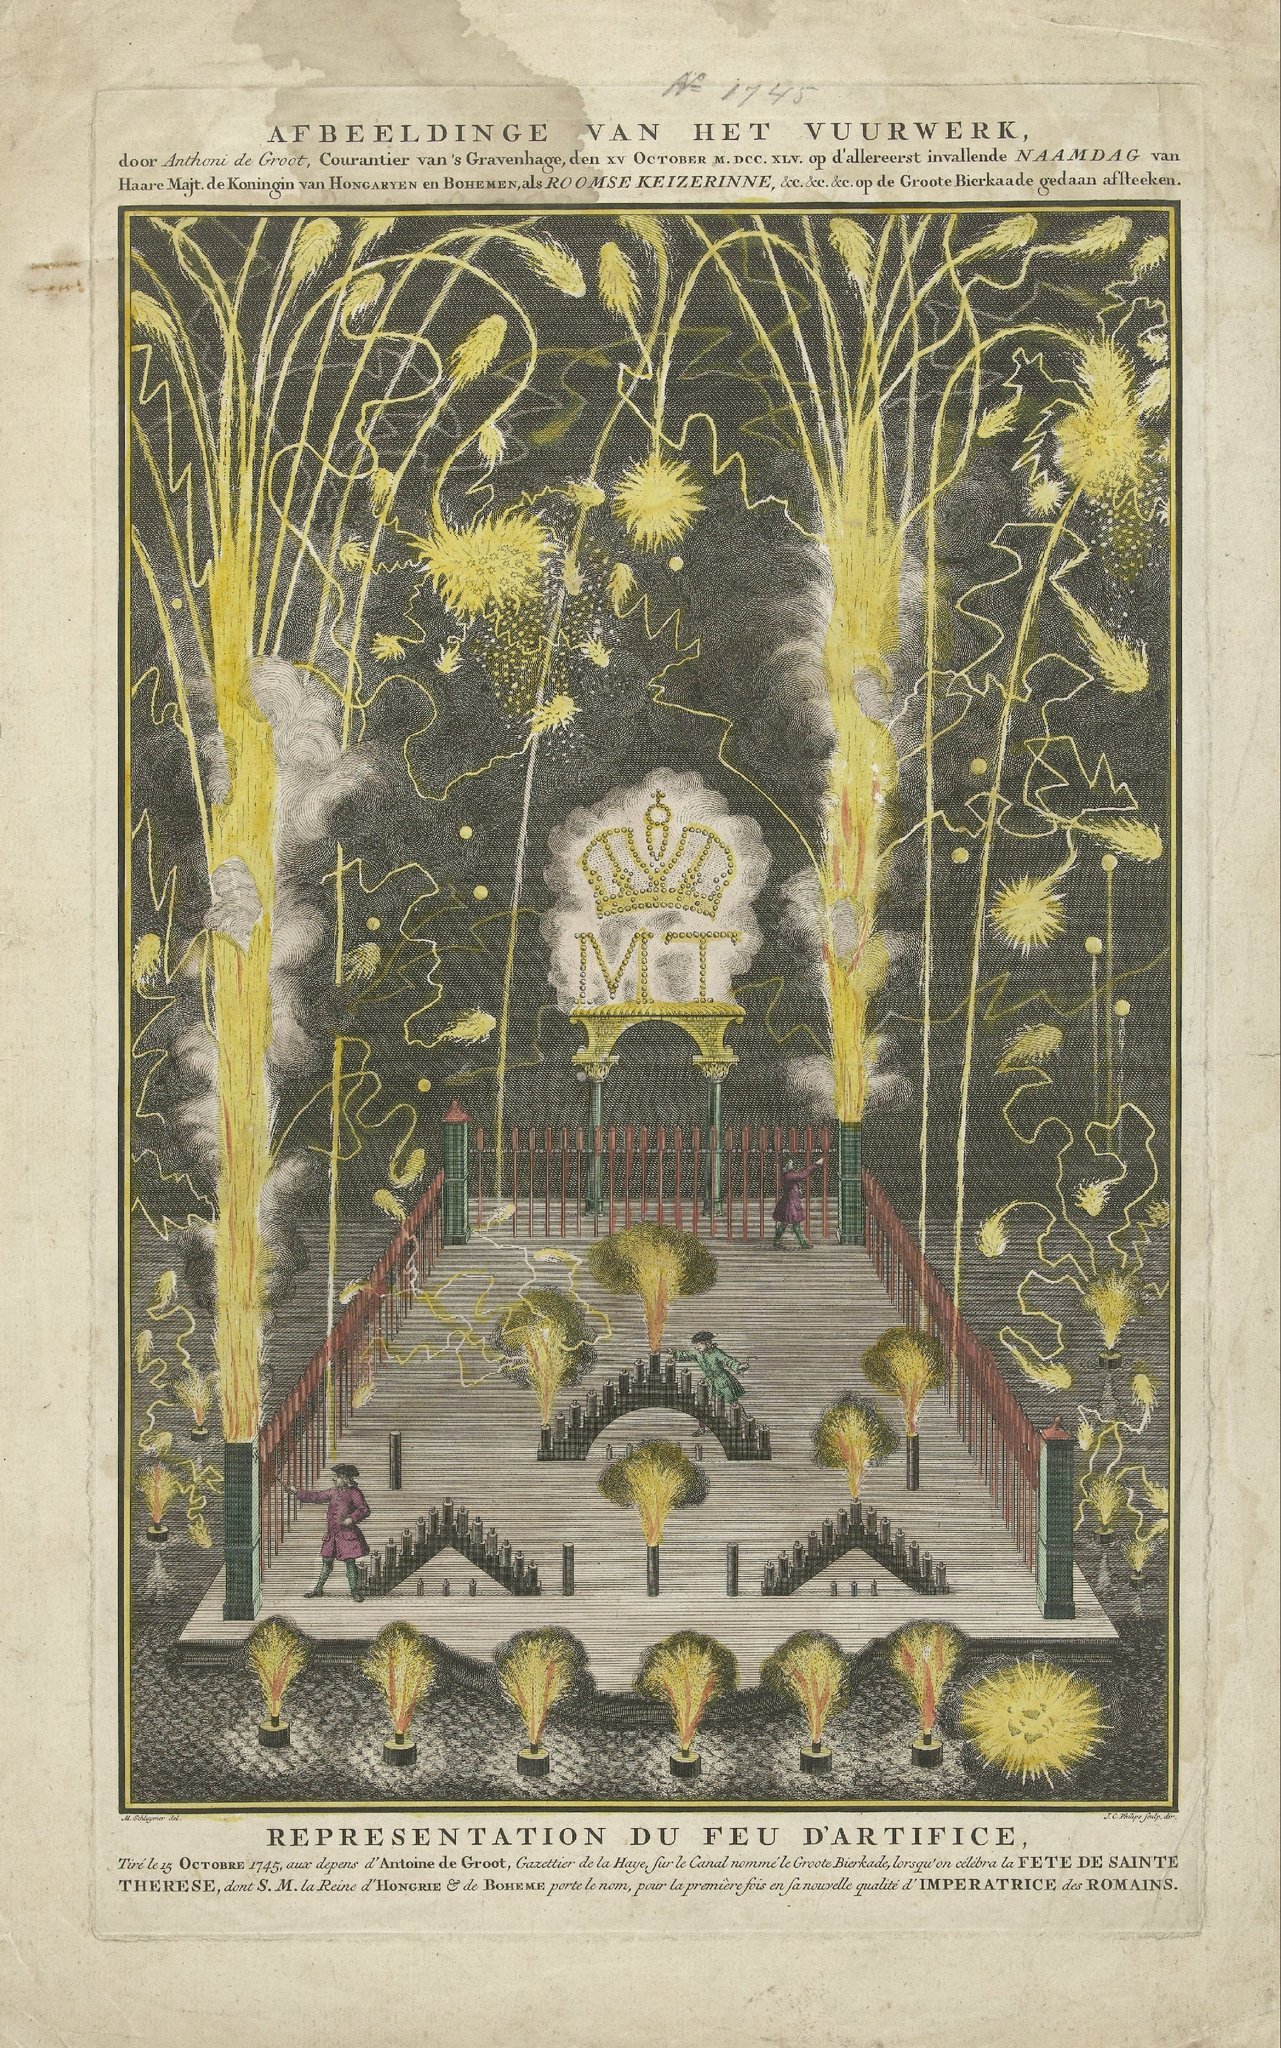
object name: print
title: Vuurwerk afgestoken op 15 oktober 1745, de naamdag van Maria Theresia, in opdracht van Anthoni de Groot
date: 1745-1747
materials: paper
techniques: engraving, etching, hand coloring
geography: northern netherlands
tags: publisher, anthoni de groot, frans i stefan (duits keizer), bonfire, fire-works (+ illumination, fire-works ~ festive activities), the hague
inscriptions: collector's mark: Lugt 2228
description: Vuurwerk afgestoken op 15 oktober 1745, de naamdag van Maria Theresia, in opdracht van de uitgever Anthoni de Groot op de Grote Bierkade te Den Haag.